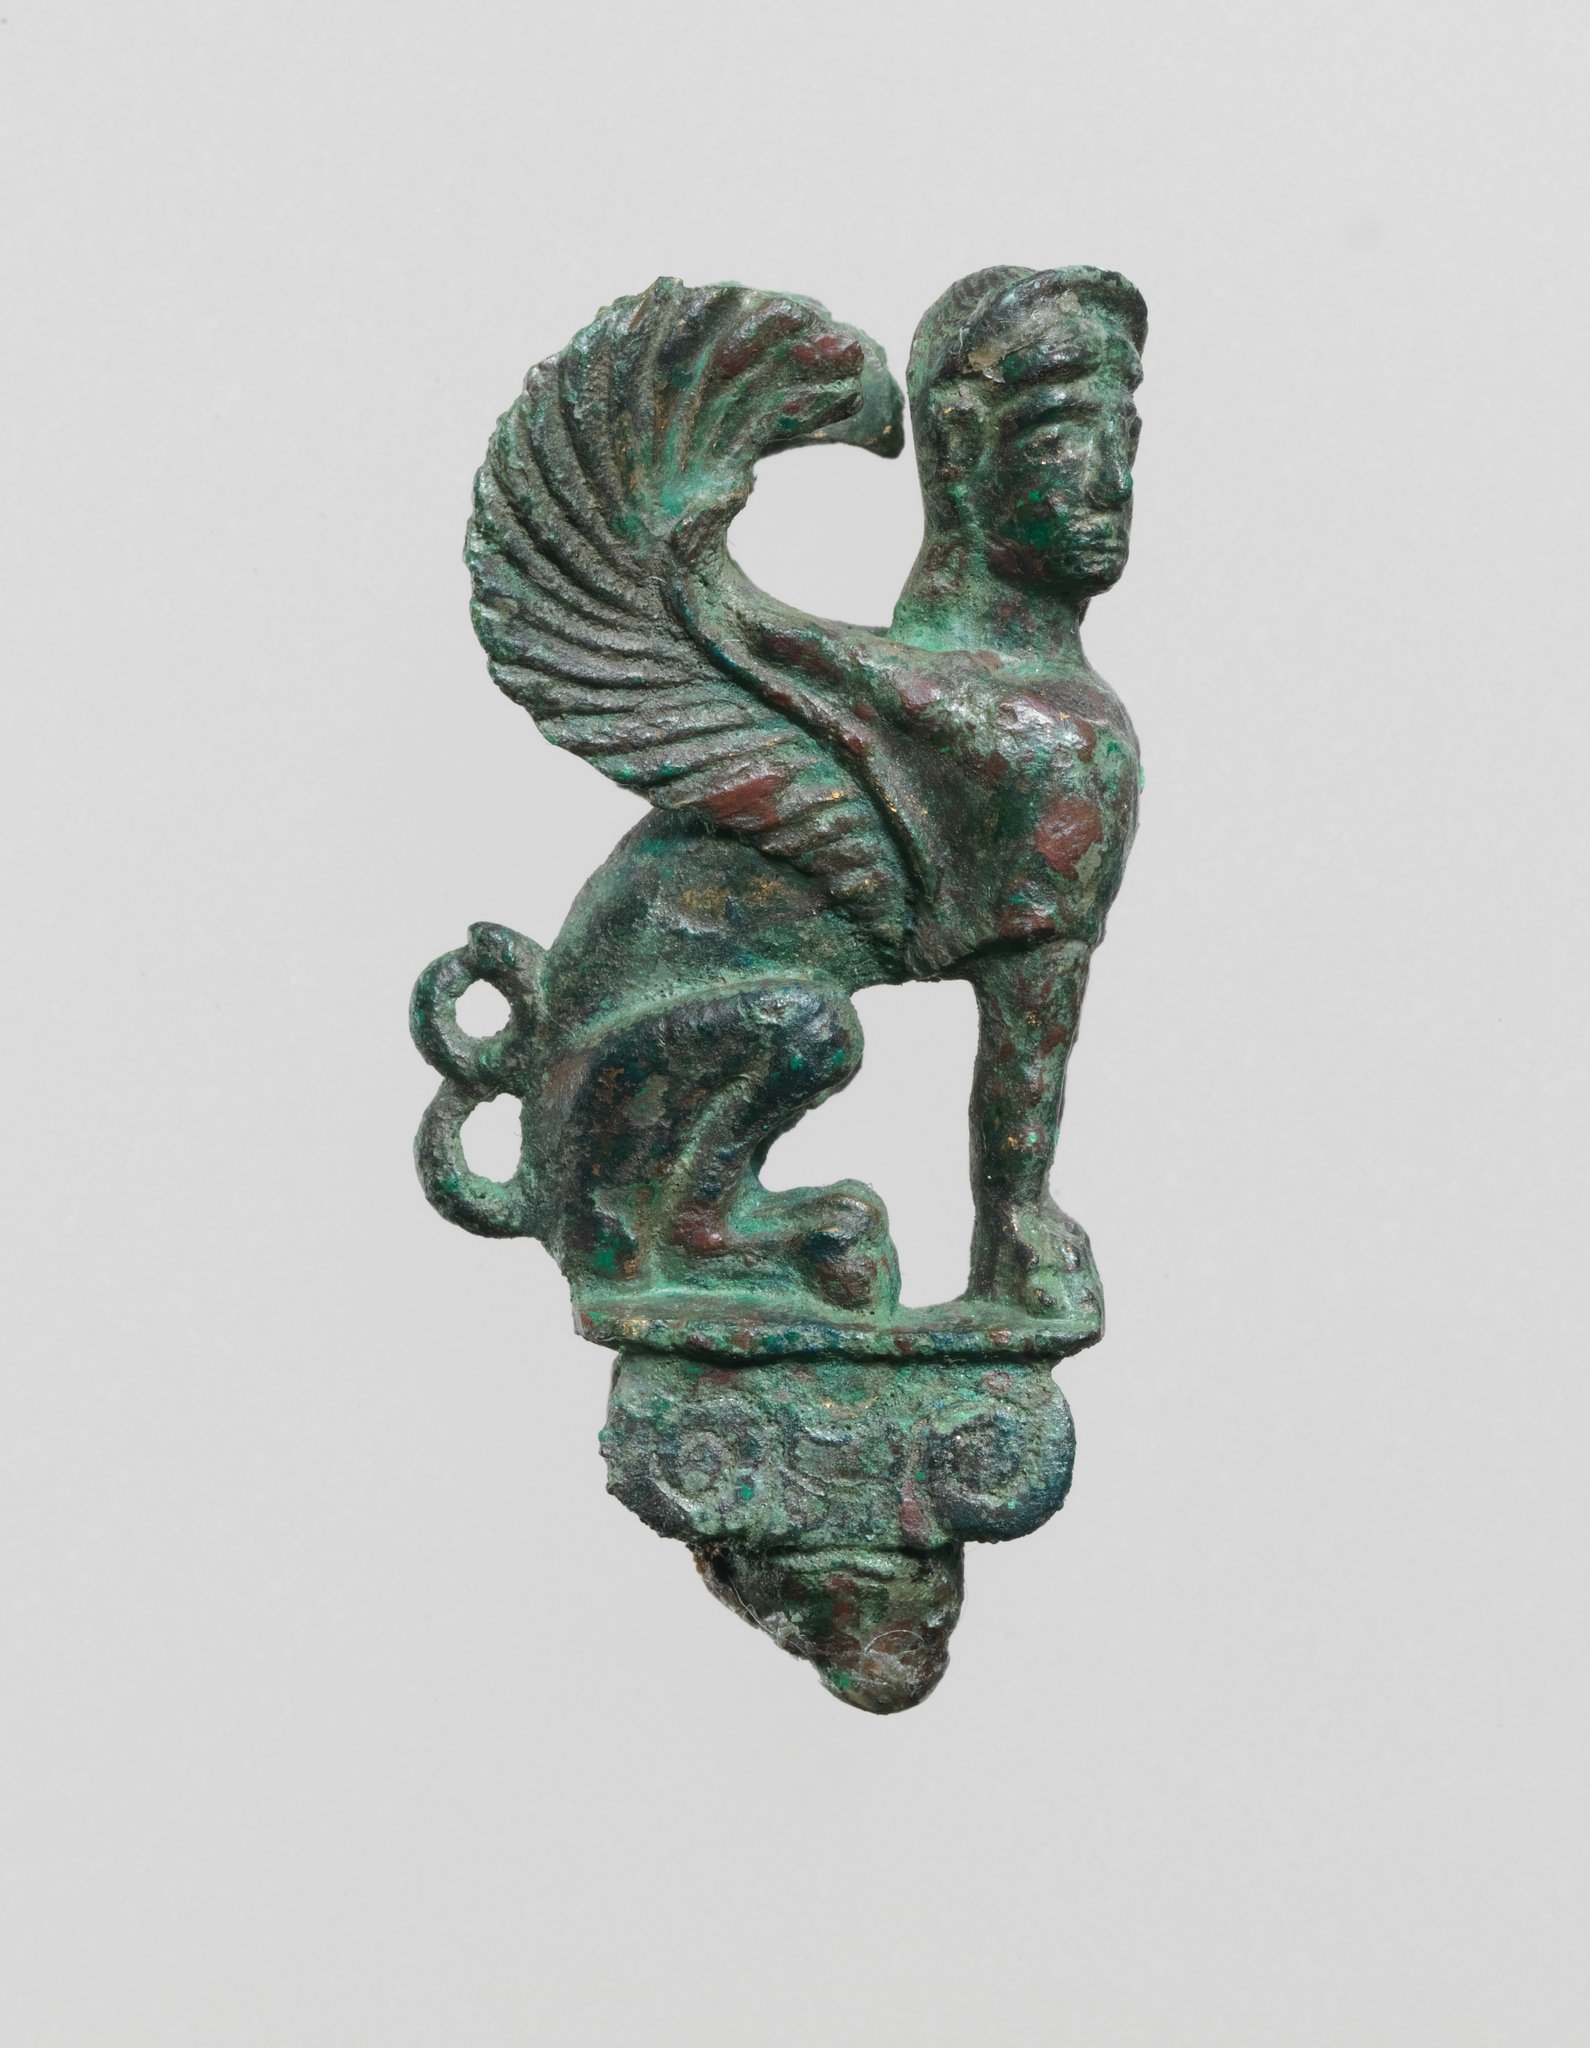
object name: statuette of a sphinx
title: Bronze statuette of a sphinx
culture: greek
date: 500-401 BCE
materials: bronze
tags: sphinx